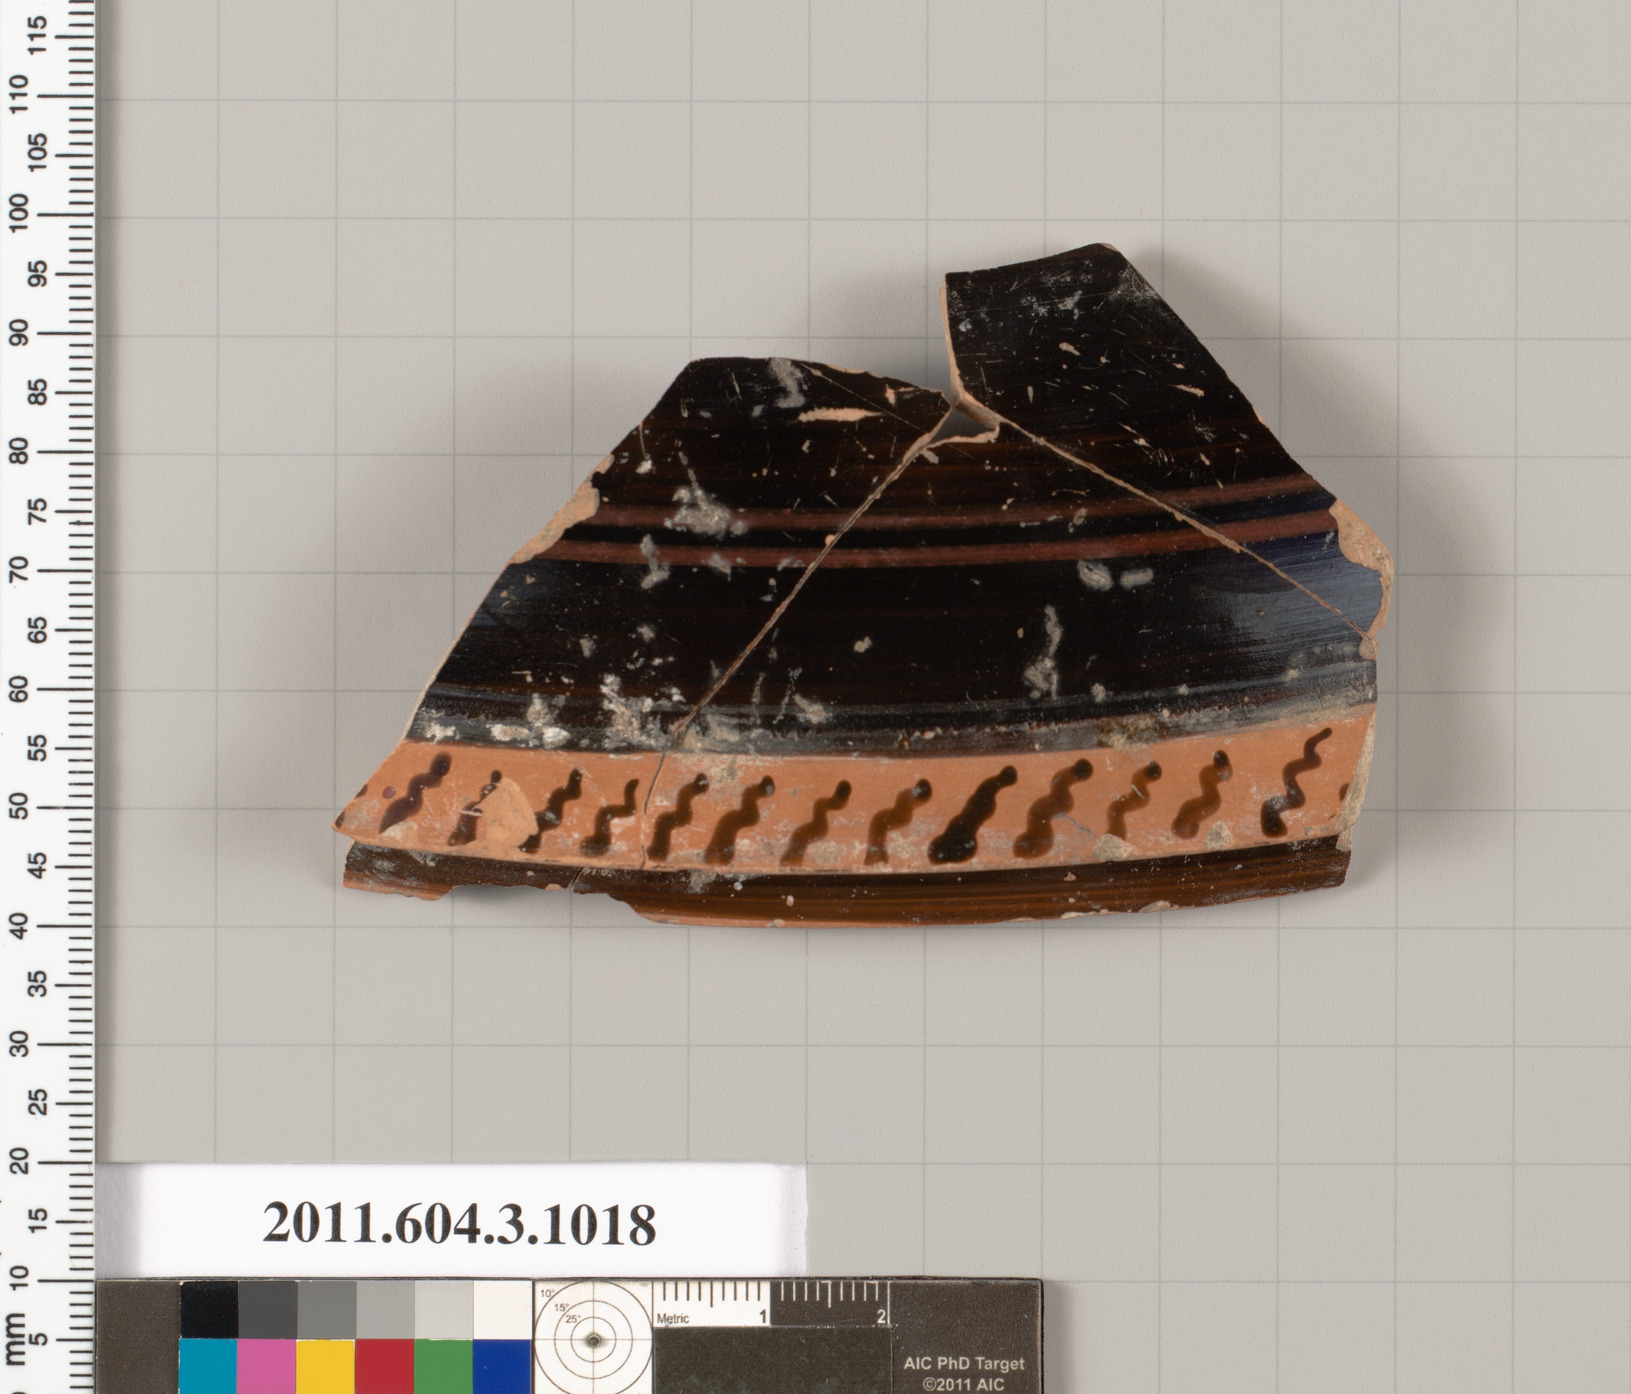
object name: lekanis fragment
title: Terracotta fragment of a lekanis (covered dish)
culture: greek, attic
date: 475-451 BCE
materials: terracotta